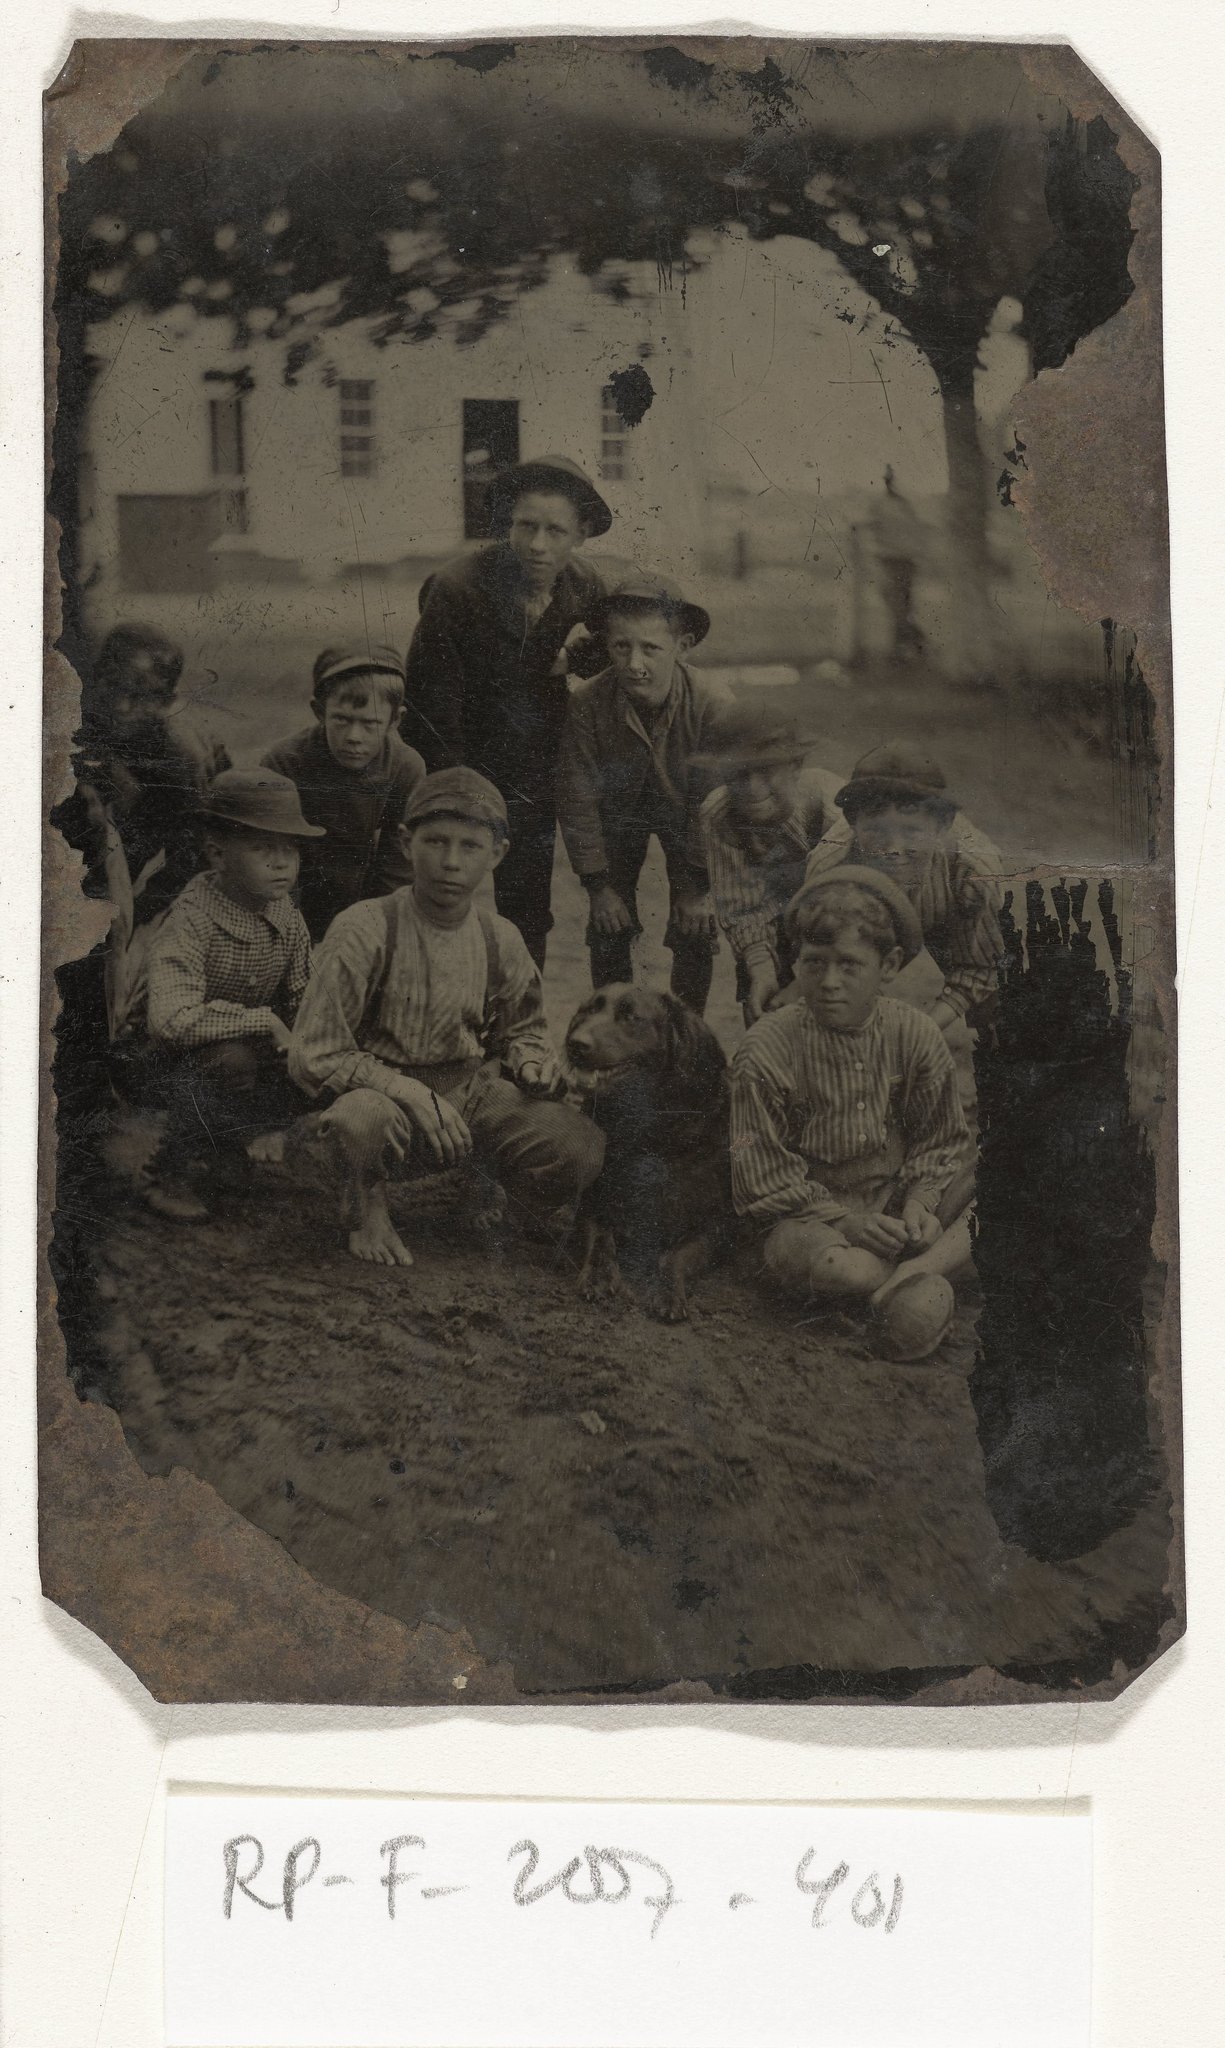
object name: photograph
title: Groepsportret van negen jongens en een hond, staand en zittend in de open lucht, met op de achtergrond een boom en een huis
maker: Anonymous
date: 1880-1910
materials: metal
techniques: ferrotyping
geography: united states